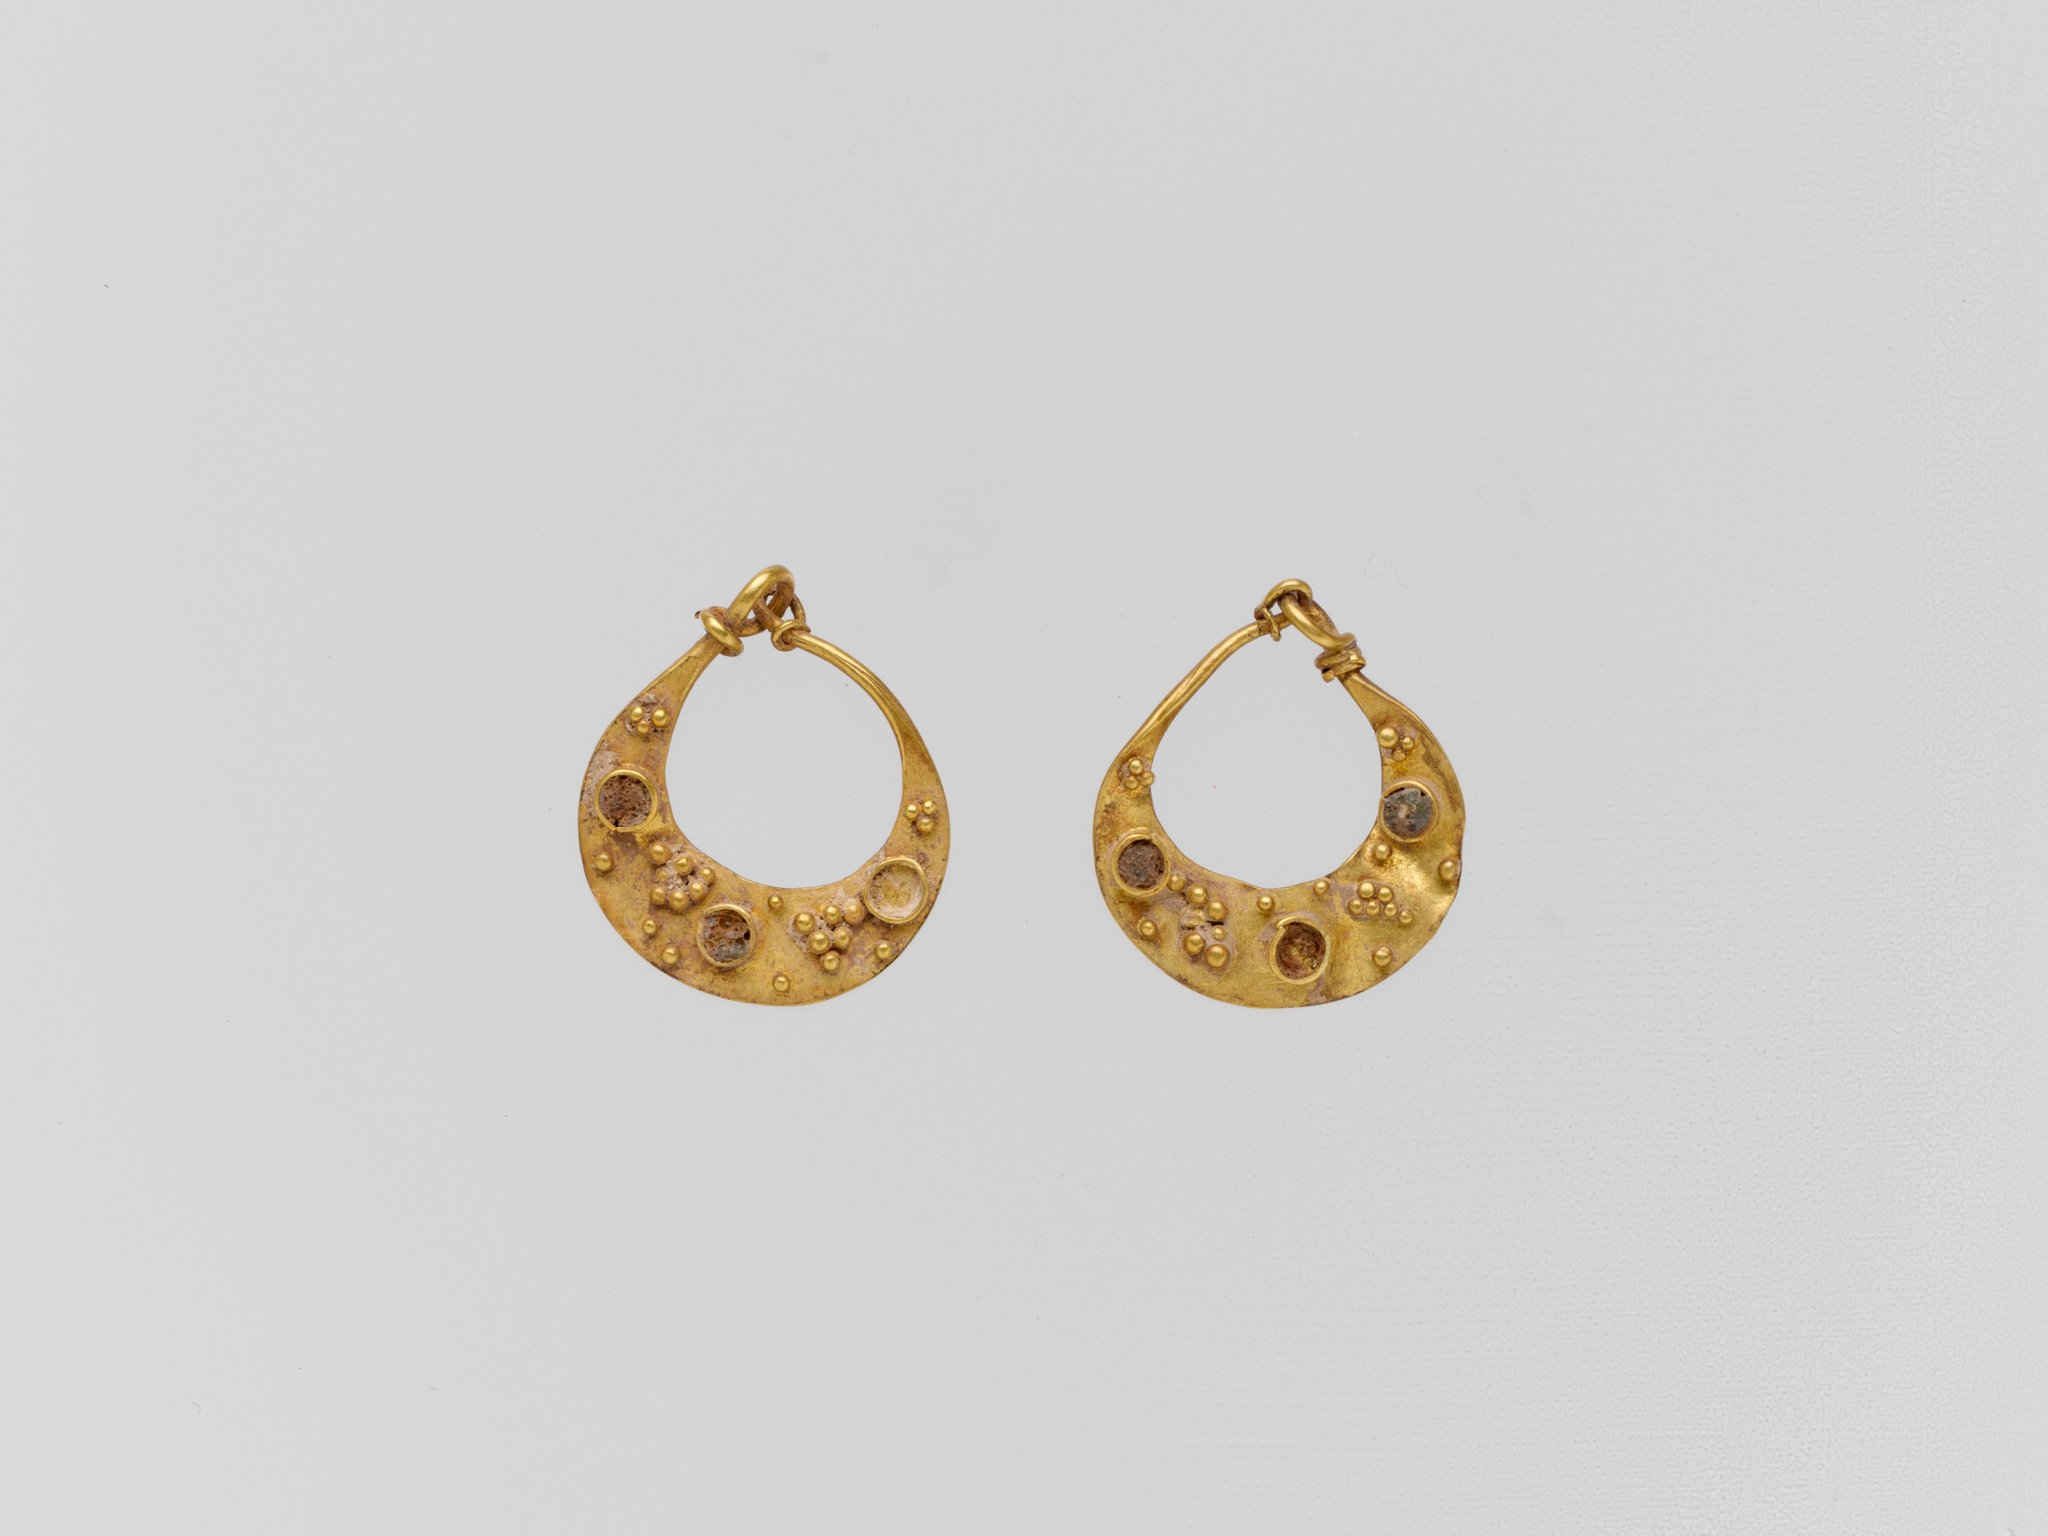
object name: earring, crescent shaped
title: Gold crescent-shaped earring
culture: cypriot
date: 500 BCE-100 CE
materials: gold